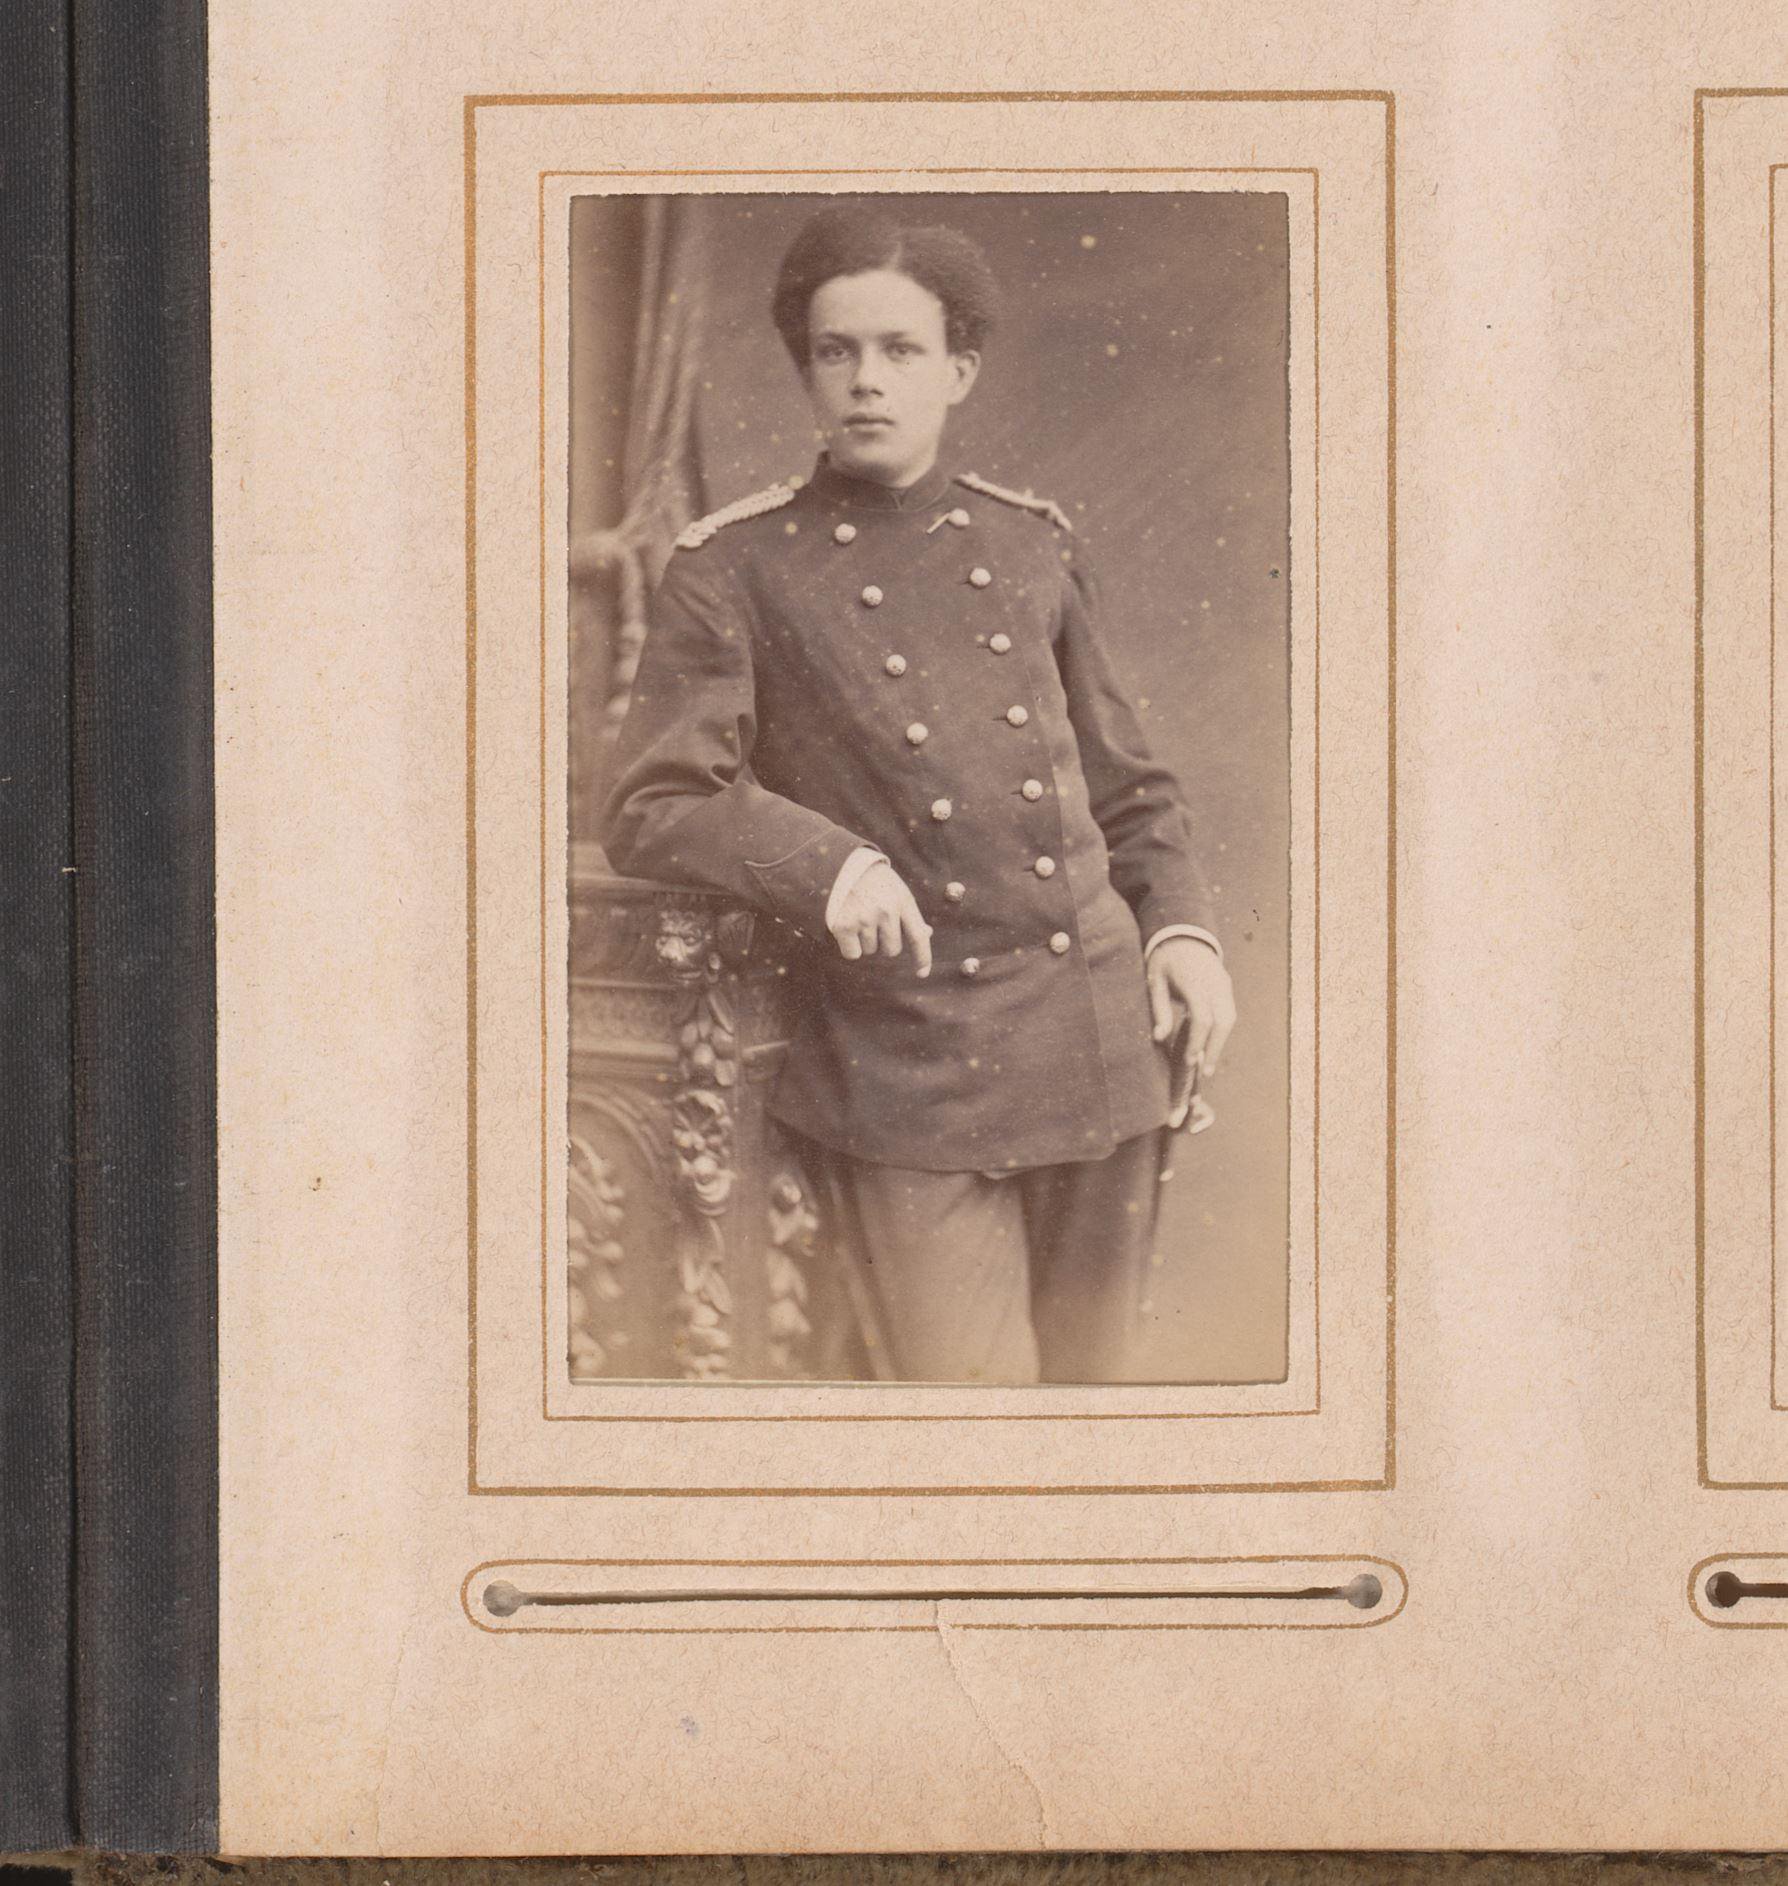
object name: photograph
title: Portret van een jongeman in uniform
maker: albert greiner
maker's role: fotograaf, fotostudio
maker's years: 1833-1890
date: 1861-1874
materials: cardboard, photographic support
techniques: albumen print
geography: amsterdam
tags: historical persons, (military) uniforms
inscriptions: inscription: ‘A. Greiner/ Photograf/ Nieuwendijk L.87/ Amsterdam’